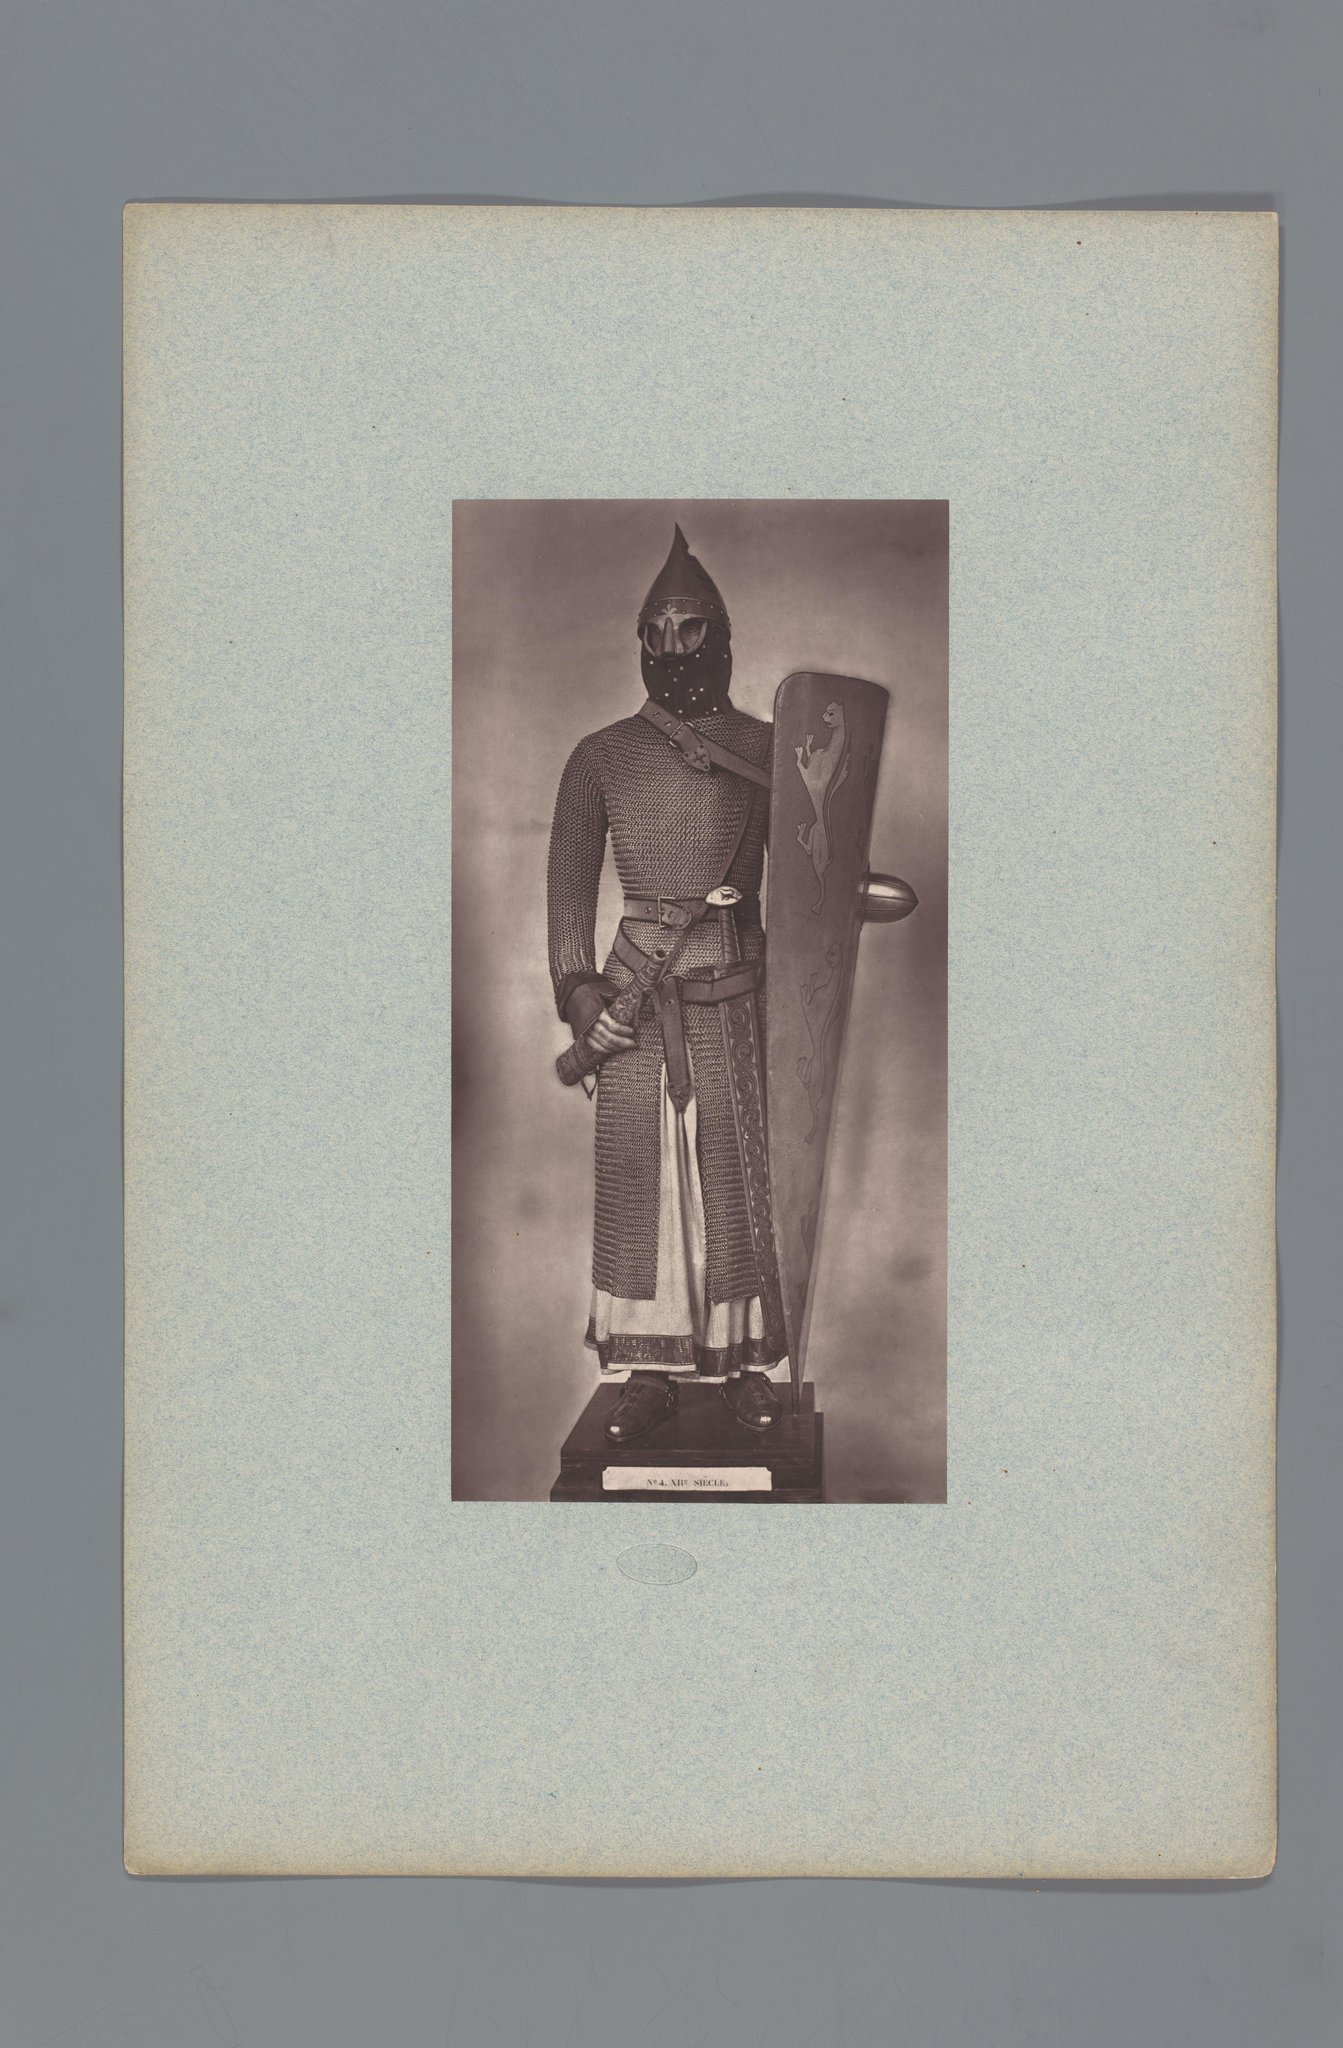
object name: photomechanical print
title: 12de-eeuws harnas uit het leger van Lodewijk VI van Frankrijk, uit de collectie van het Musée d'Artillerie in Parijs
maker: Anonymous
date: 1877-1882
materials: paper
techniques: woodburytype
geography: paris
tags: armour, helved weapons, polearms (for striking, hacking, thrusting): lance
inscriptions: check stamp: ‘PHOTOGLYPTIE/ LEMERCIER ET Cie/ PARIS’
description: Deze prent maakt deel uit van een omslag met 36 prenten, een titelblad en een lijst van afbeeldingen.